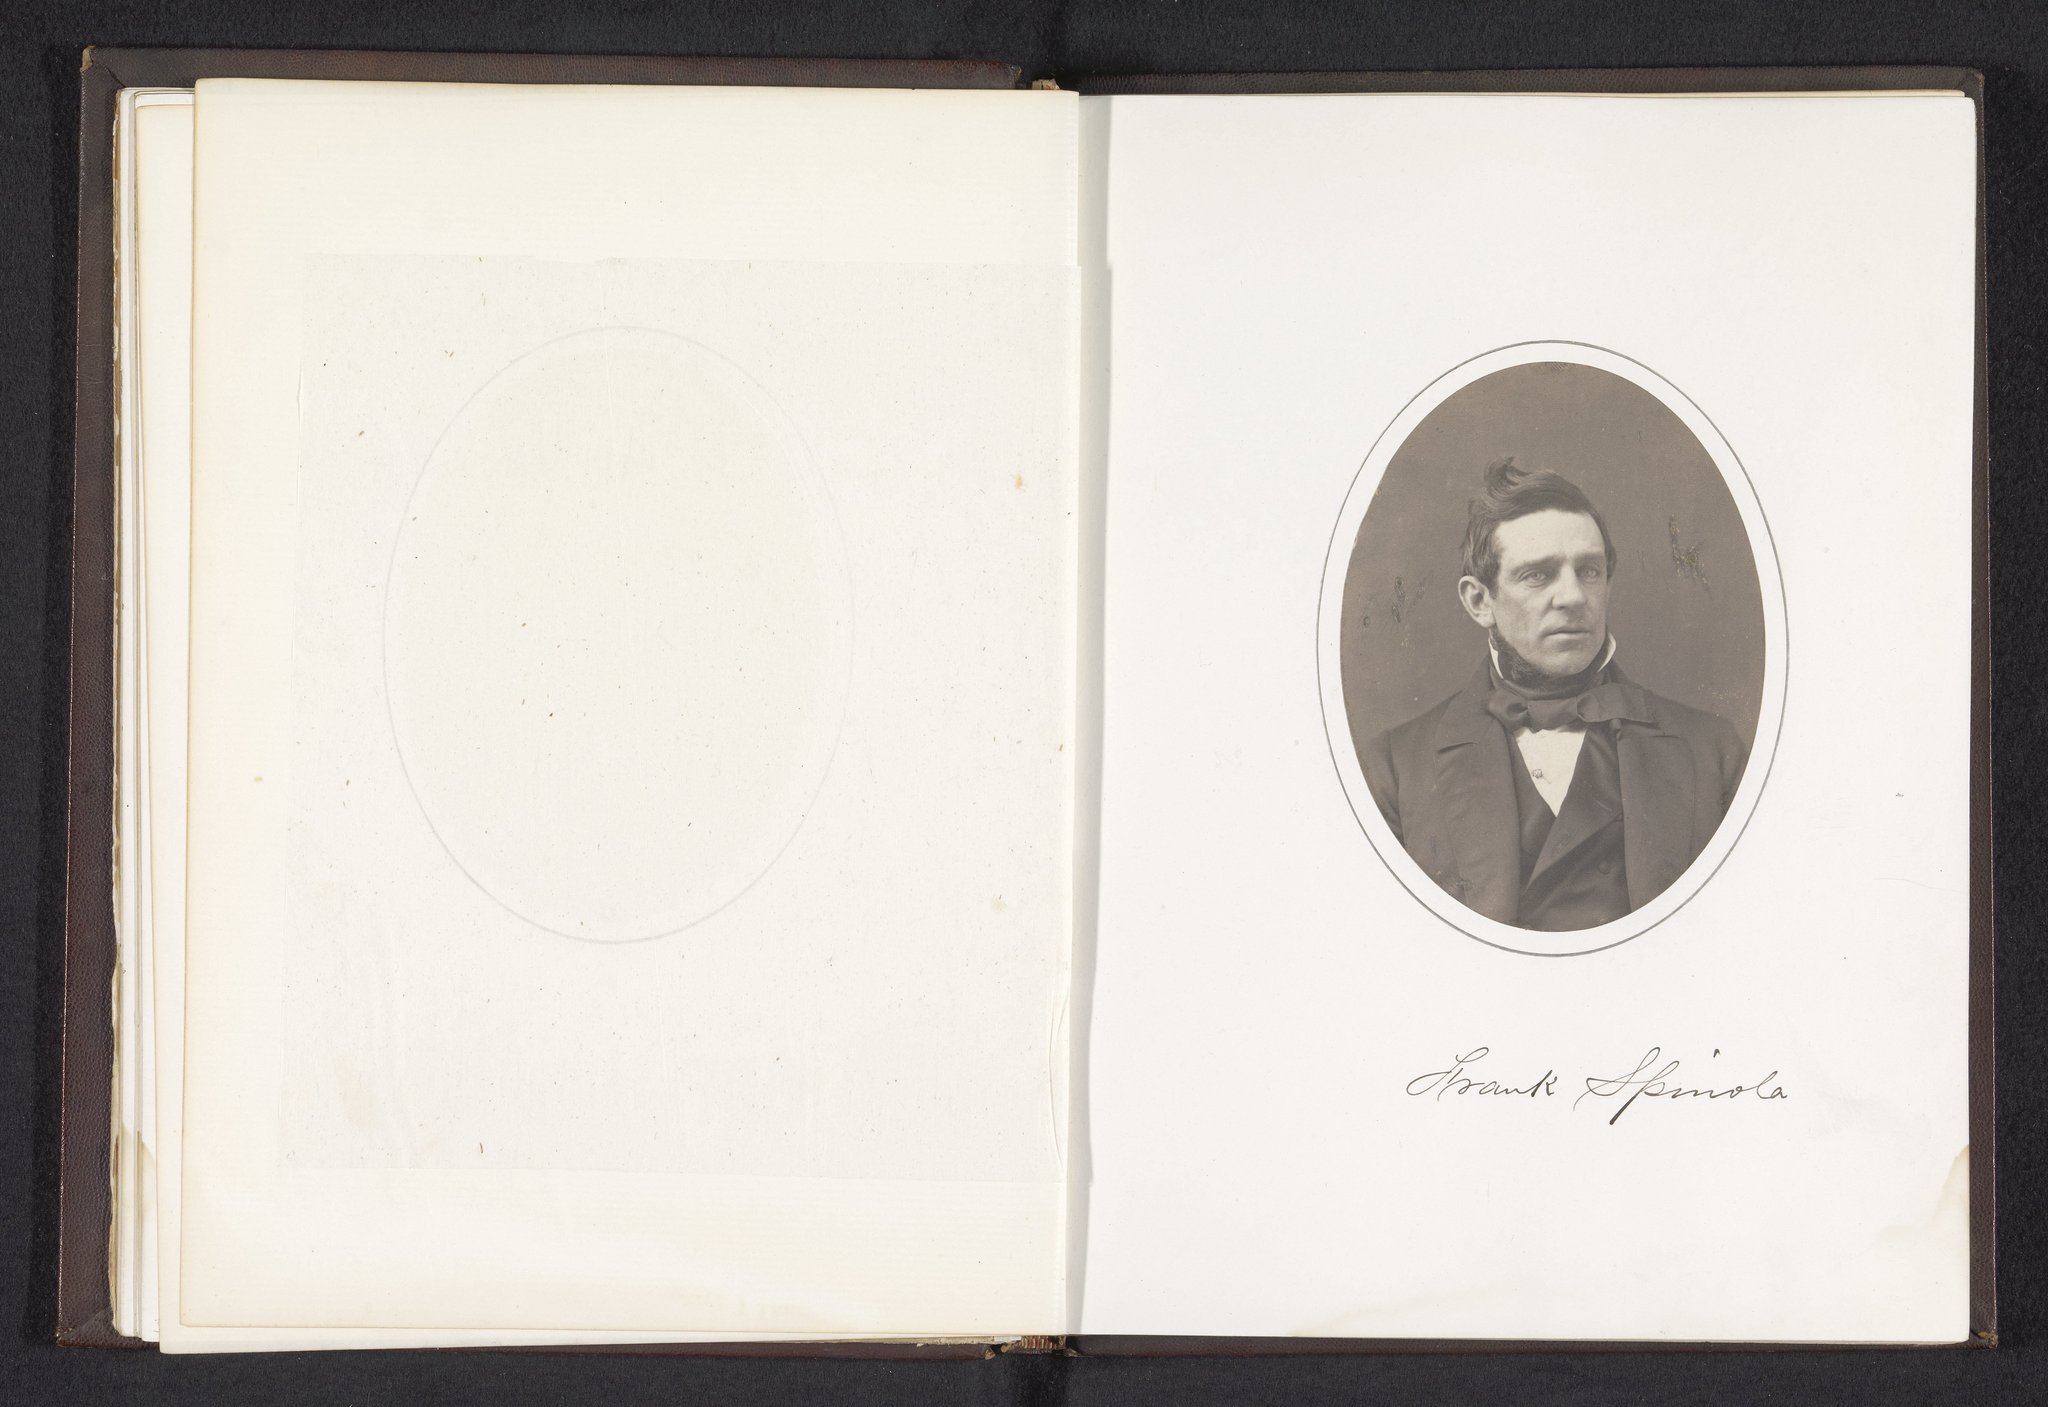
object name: photograph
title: Portret van Senaatslid Francis B. Spinola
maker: d.t.t. davie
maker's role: publisher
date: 1858-1859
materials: photographic support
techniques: salted paper print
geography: new york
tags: politician, e.g. party leader, upper house, senate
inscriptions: inscription: ‘Frank Spinola’